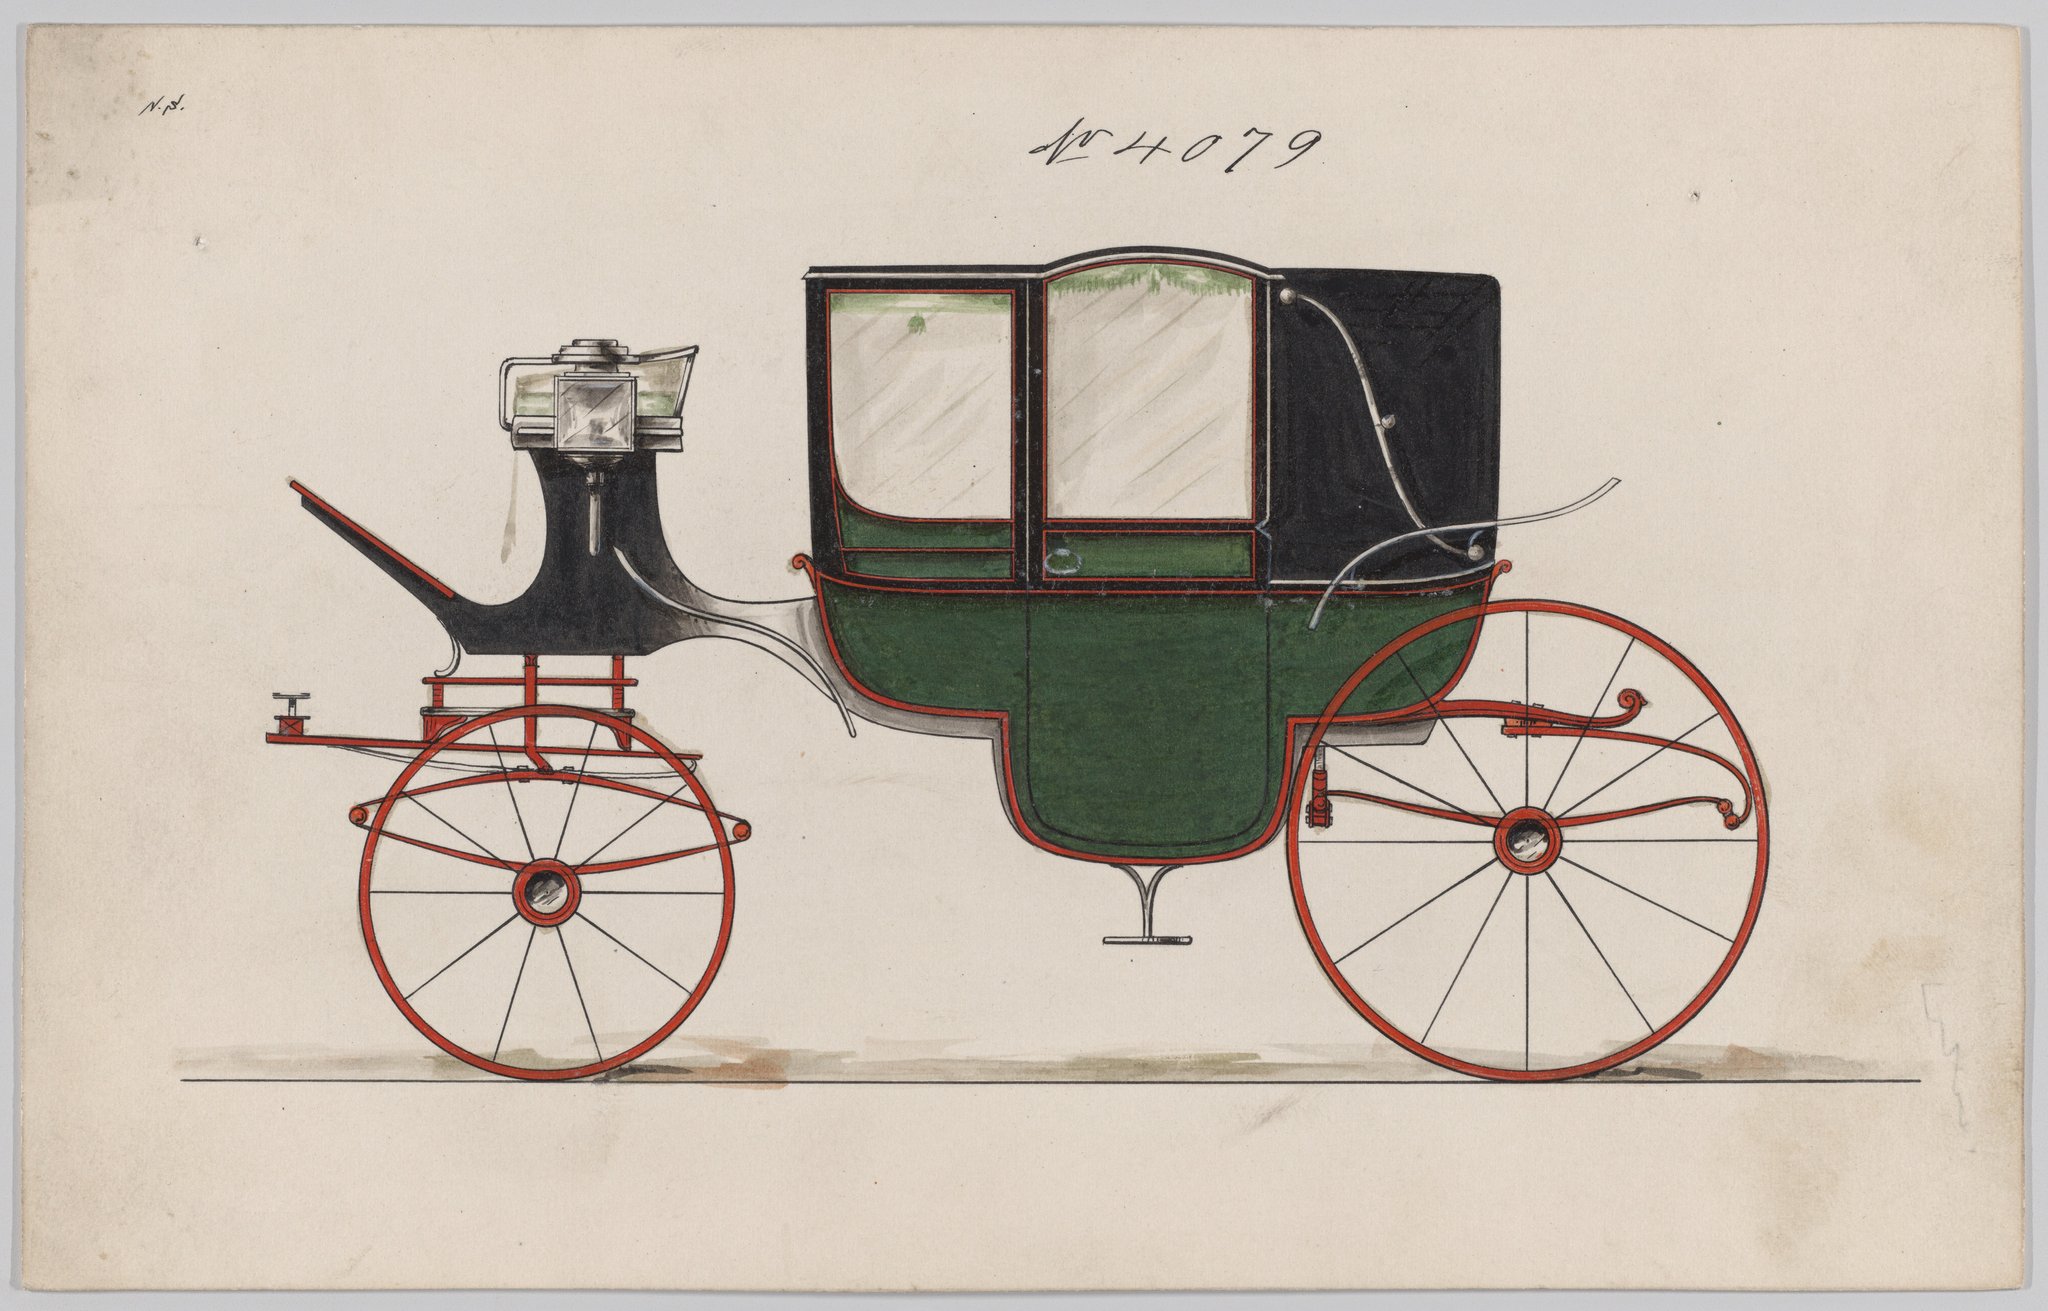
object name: drawing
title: Design for Landau, No. 4079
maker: brewster & co.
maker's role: manufacturer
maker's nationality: american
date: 1890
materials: gouache, gum arabic, ink, watercolor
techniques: pen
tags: carriages